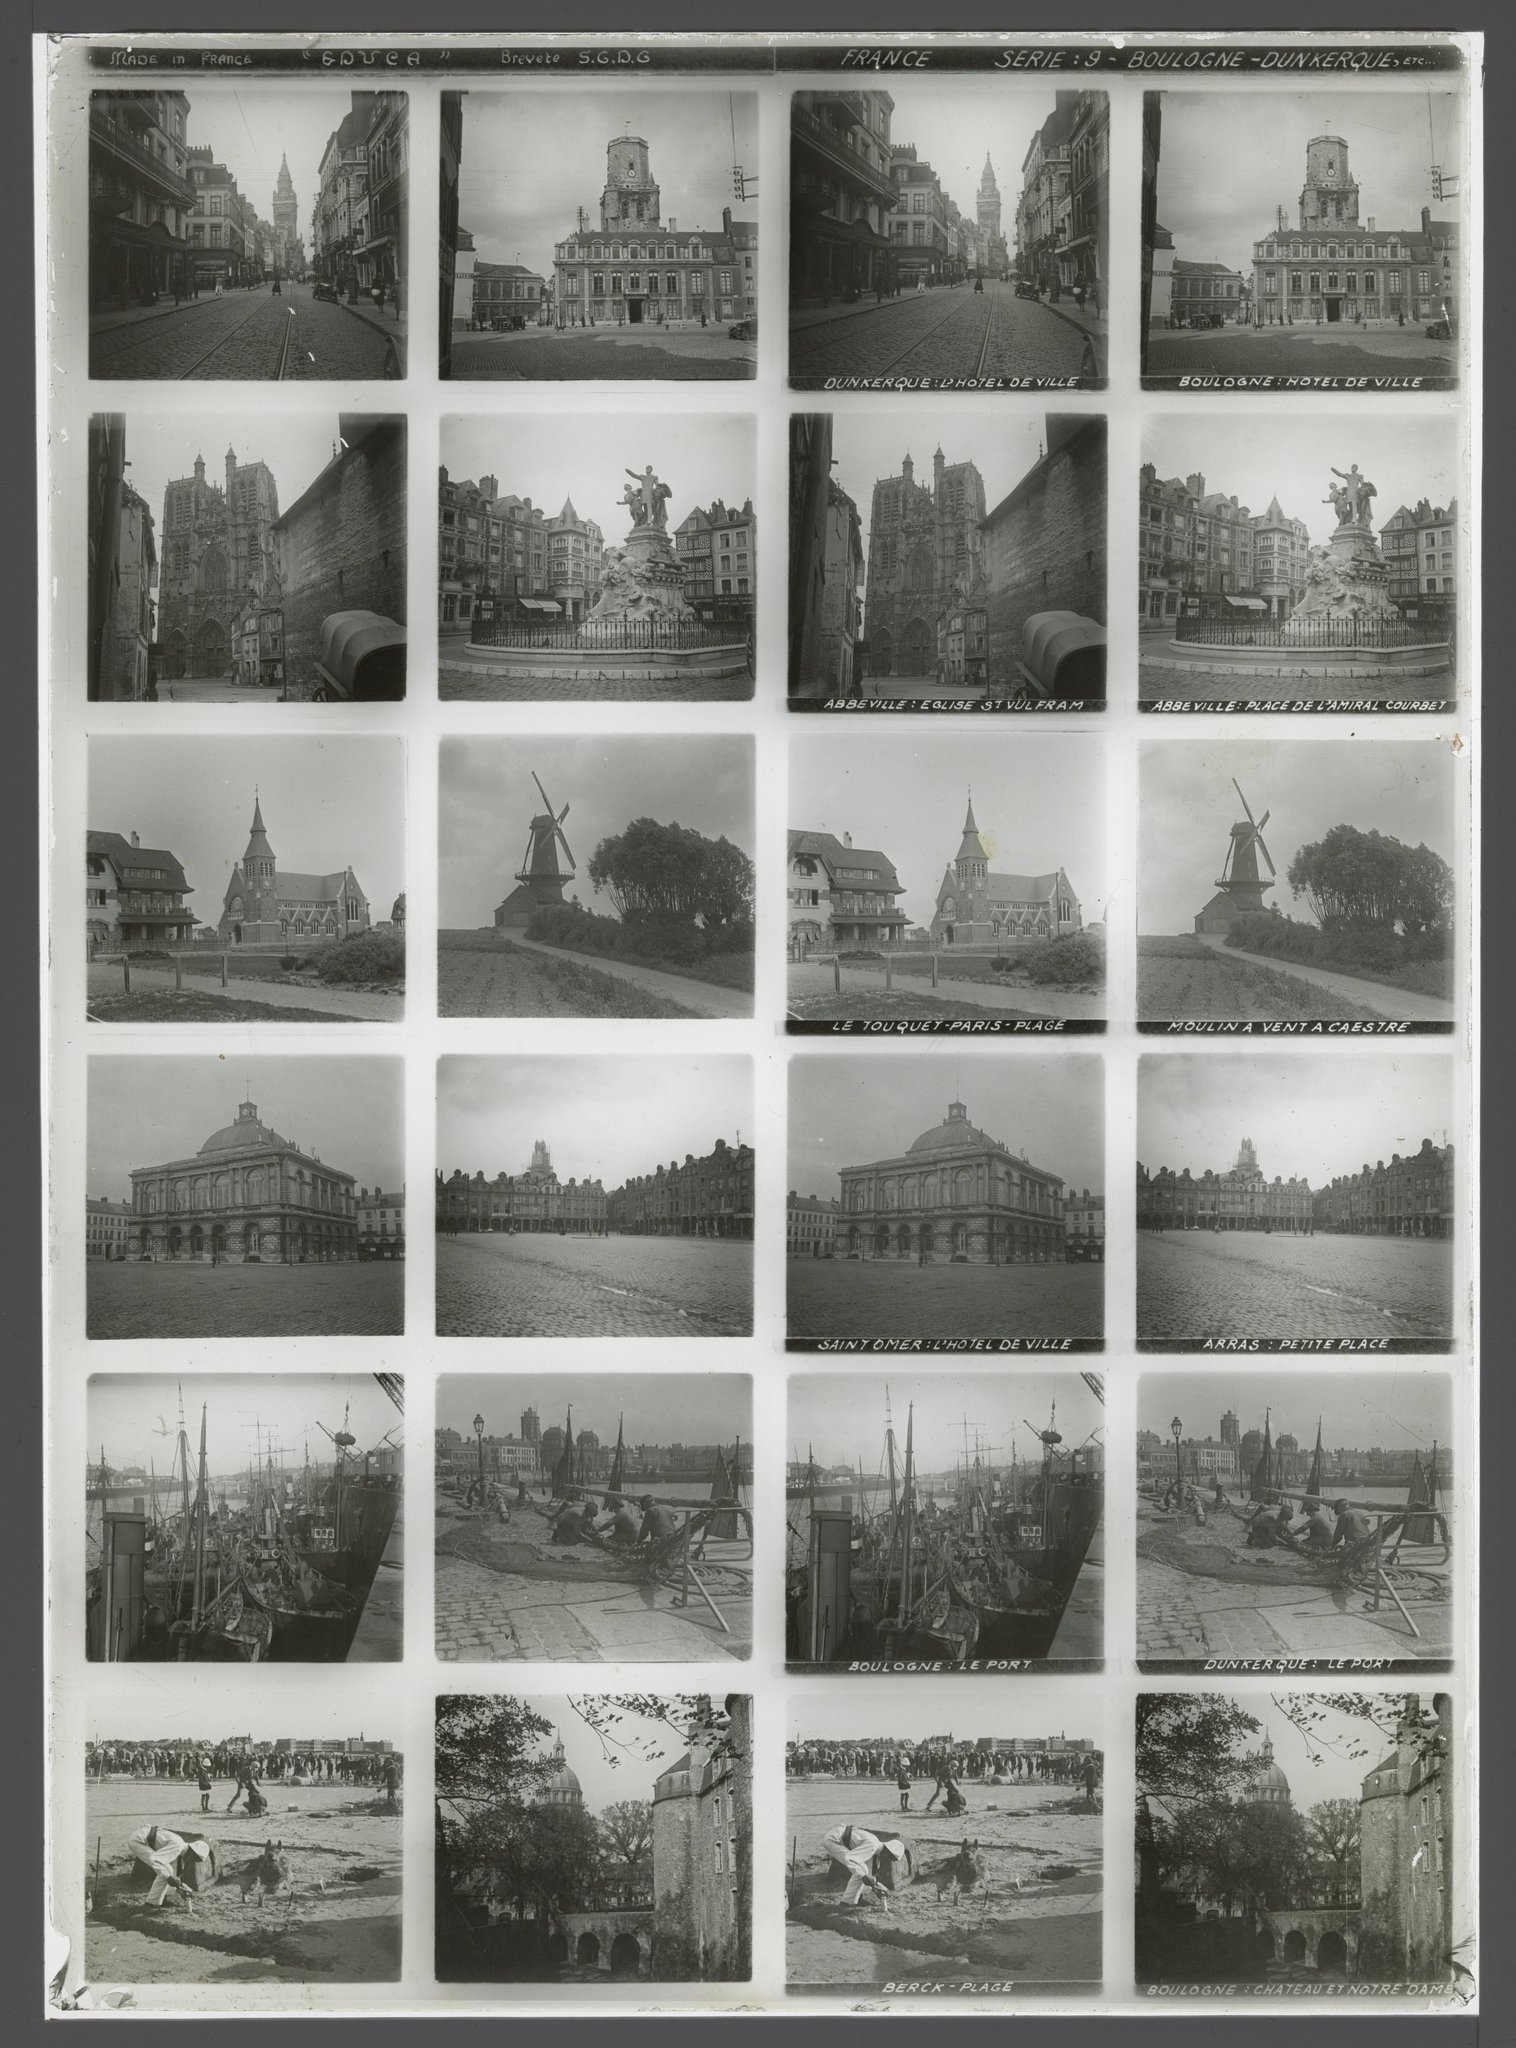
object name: stereoscopic photograph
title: Twaalf stereoscopische opnamen van monumenten en plaatsen in de omgeving van Boulogne en Duinkerke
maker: Anonymous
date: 1920-1925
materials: glass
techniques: gelatin silver transparency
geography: paris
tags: harbour, peninsula, windmill, beach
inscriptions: inscription: ‘Made in France (...) Brevete S.G.D.G. (...)’